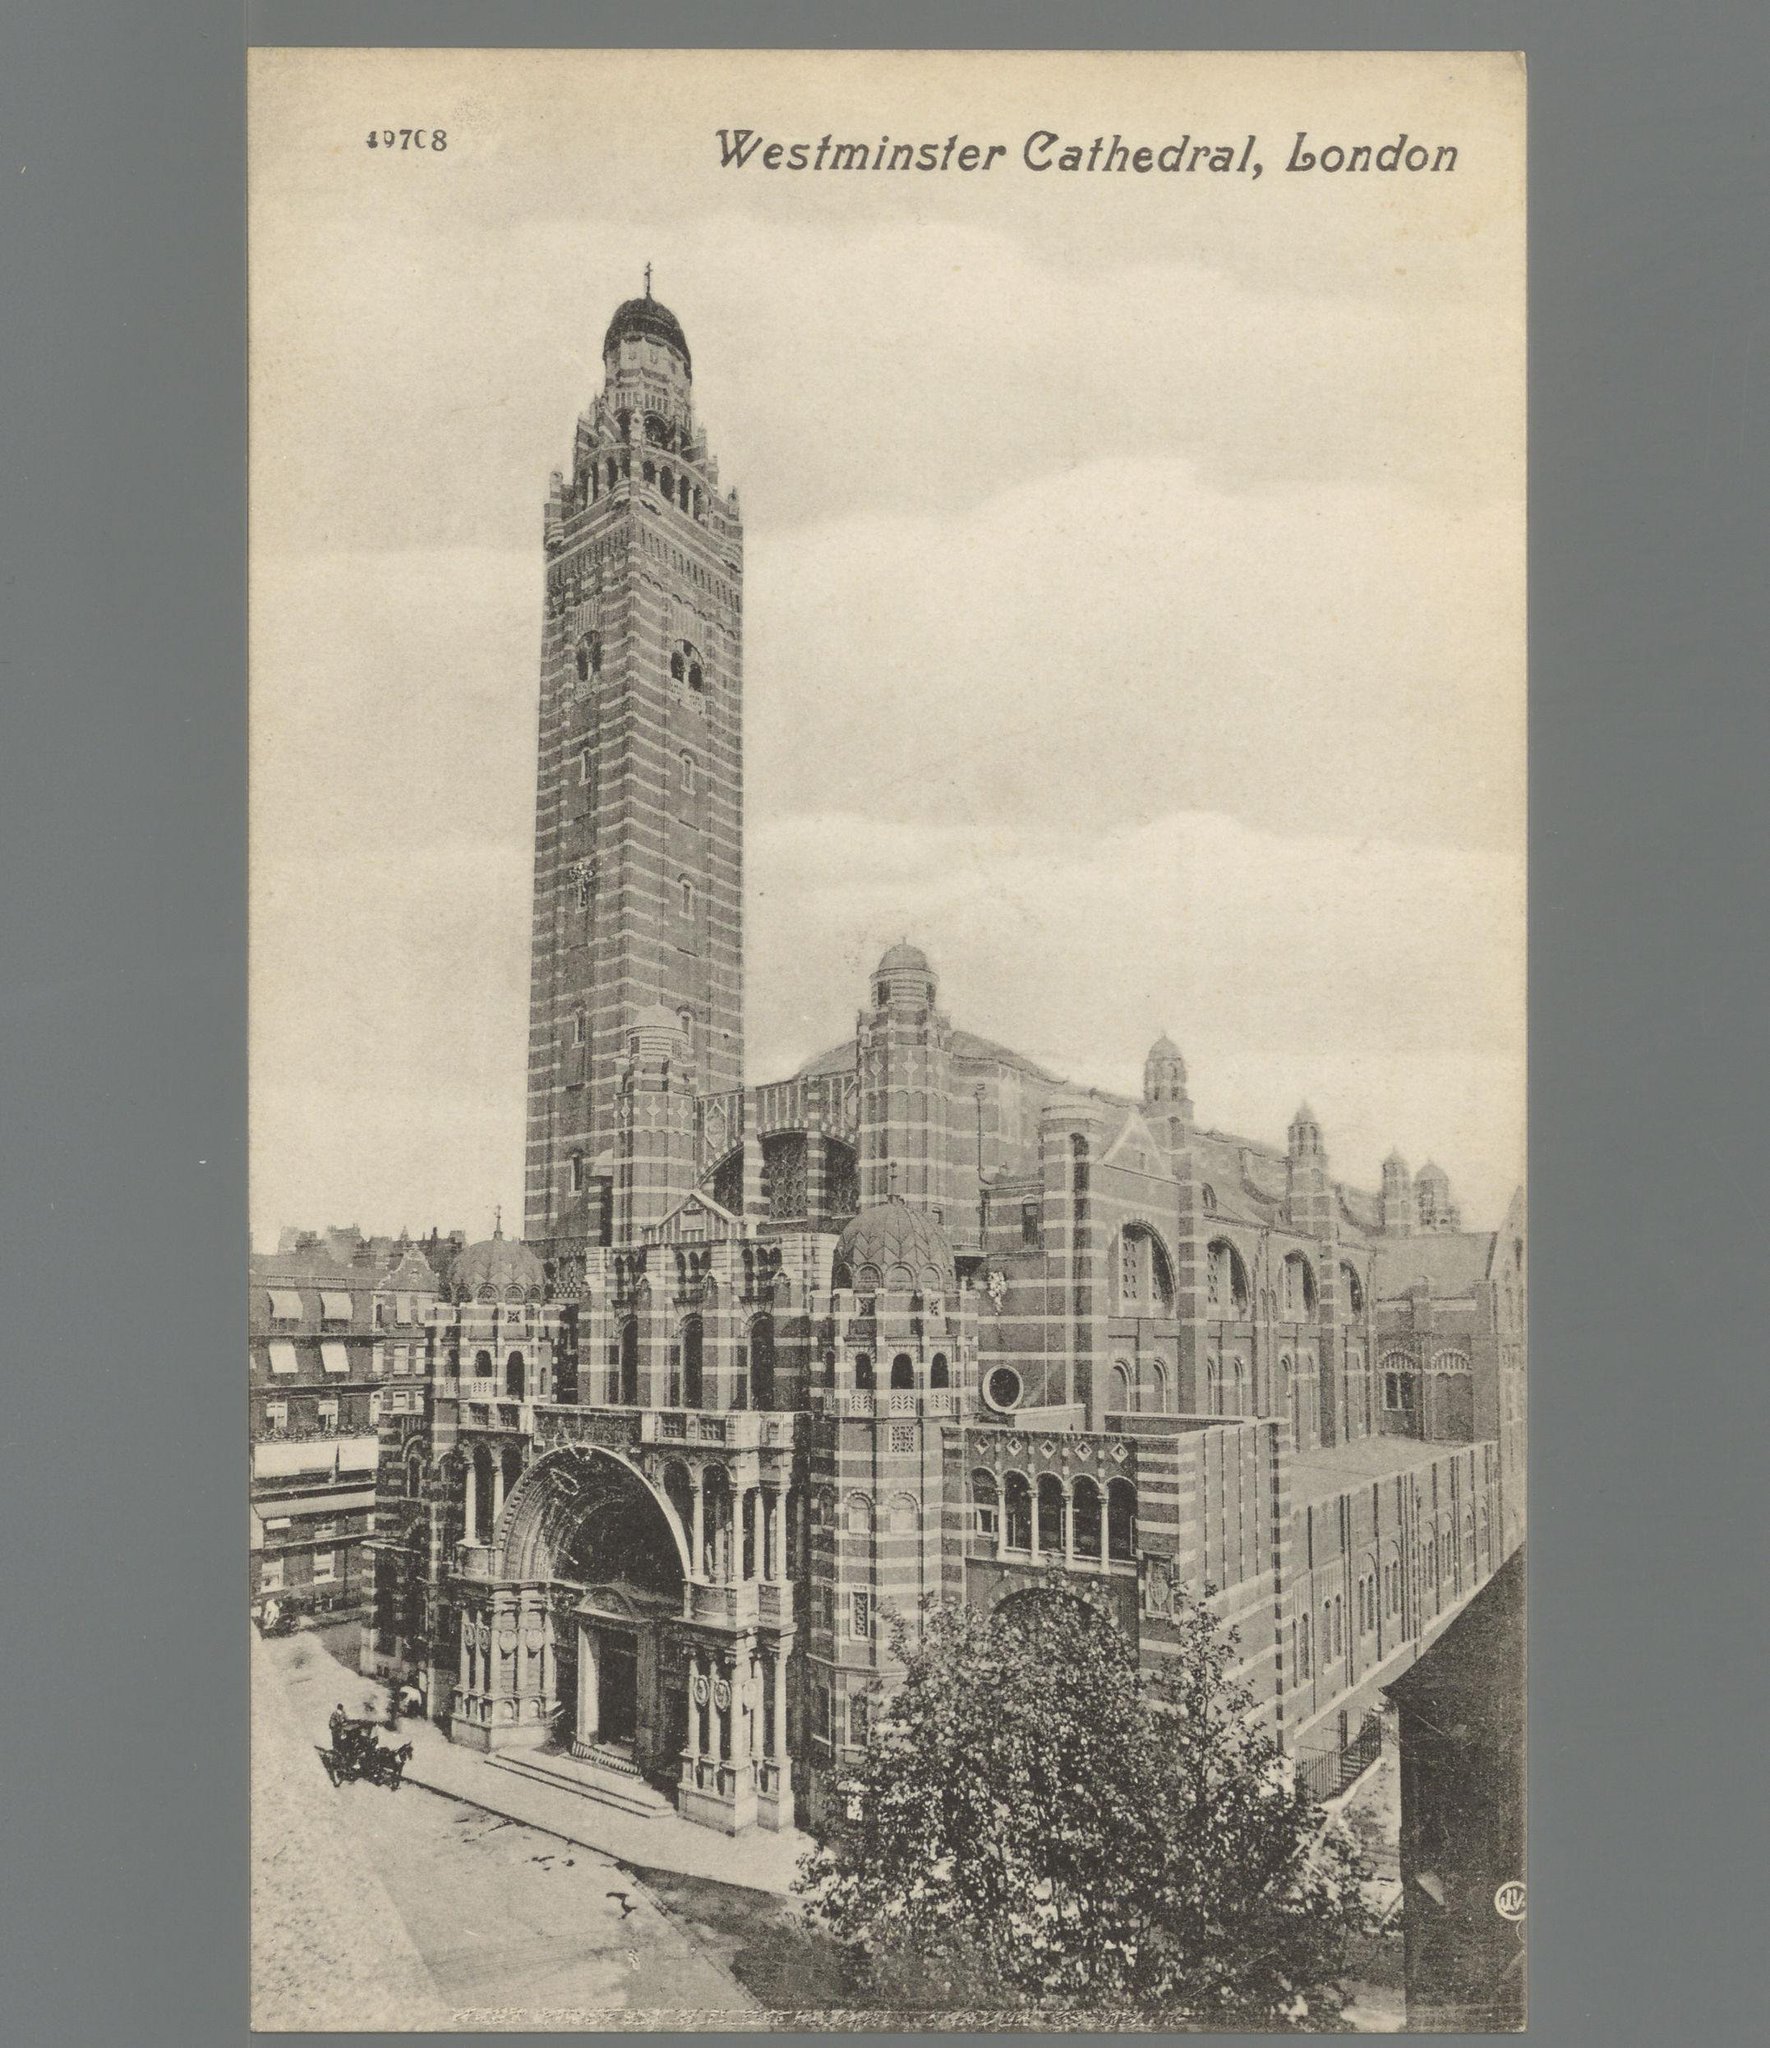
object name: ansichtkaart, prentbriefkaart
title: Westminster Cathedral, London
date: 1902-1930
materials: cardboard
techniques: photograph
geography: dundee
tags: church (exterior)